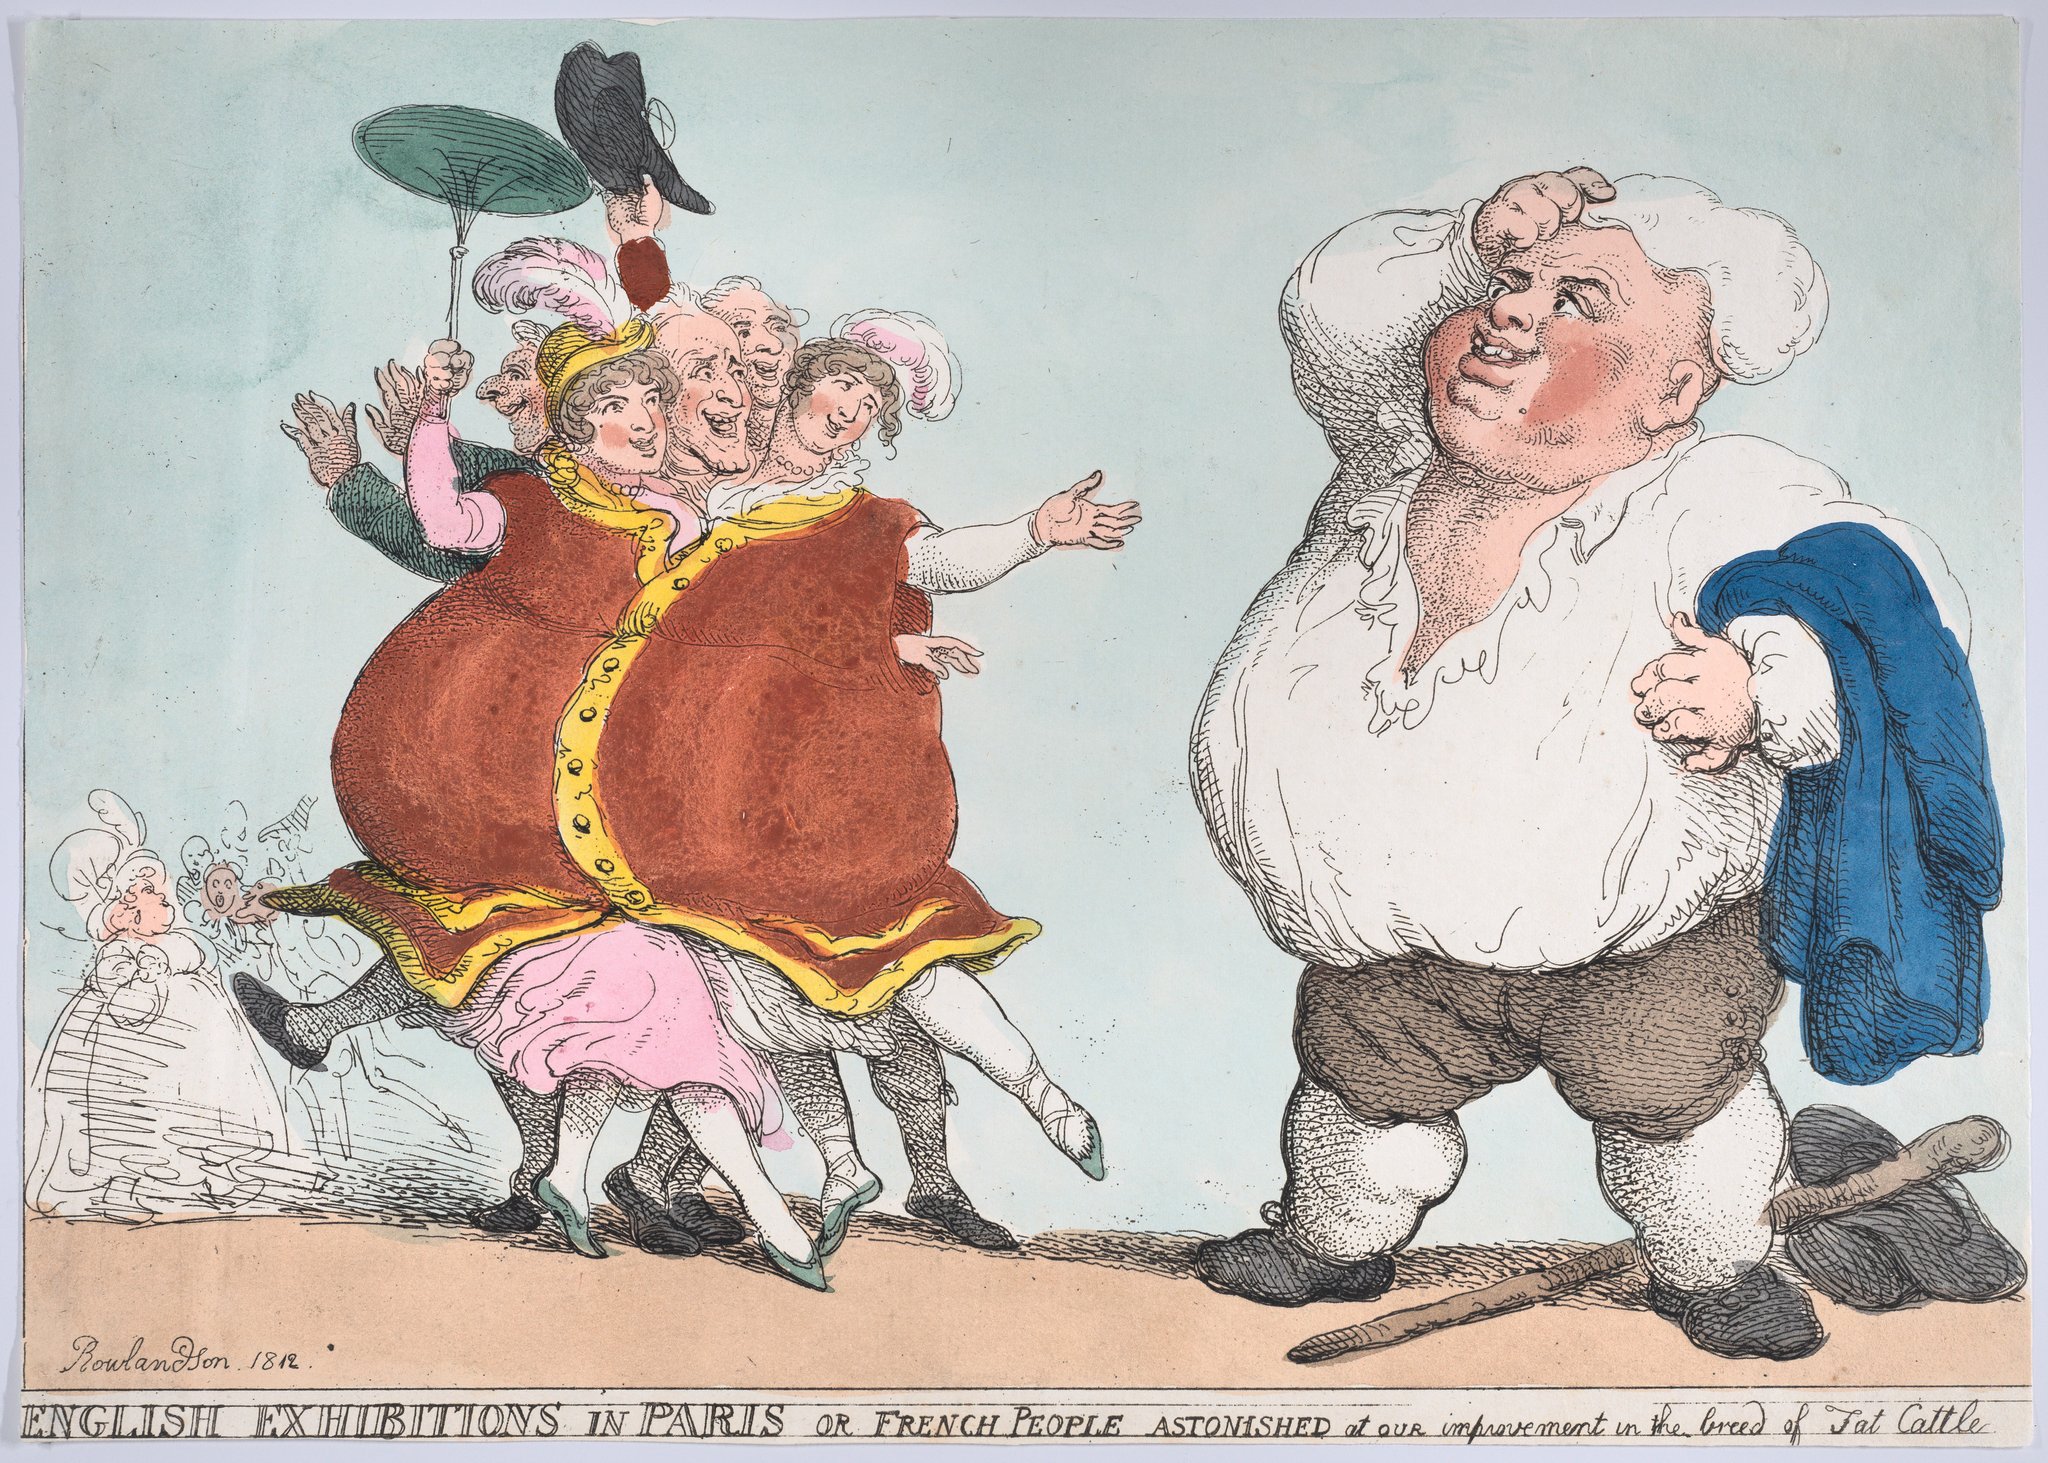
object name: print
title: English Exhibitions in Paris or French People Astonished at Our Improvement in the Breed of Fat Cattle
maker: thomas rowlandson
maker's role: artist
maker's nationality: british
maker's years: 1757-1827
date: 1812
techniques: etching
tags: satire,men,women